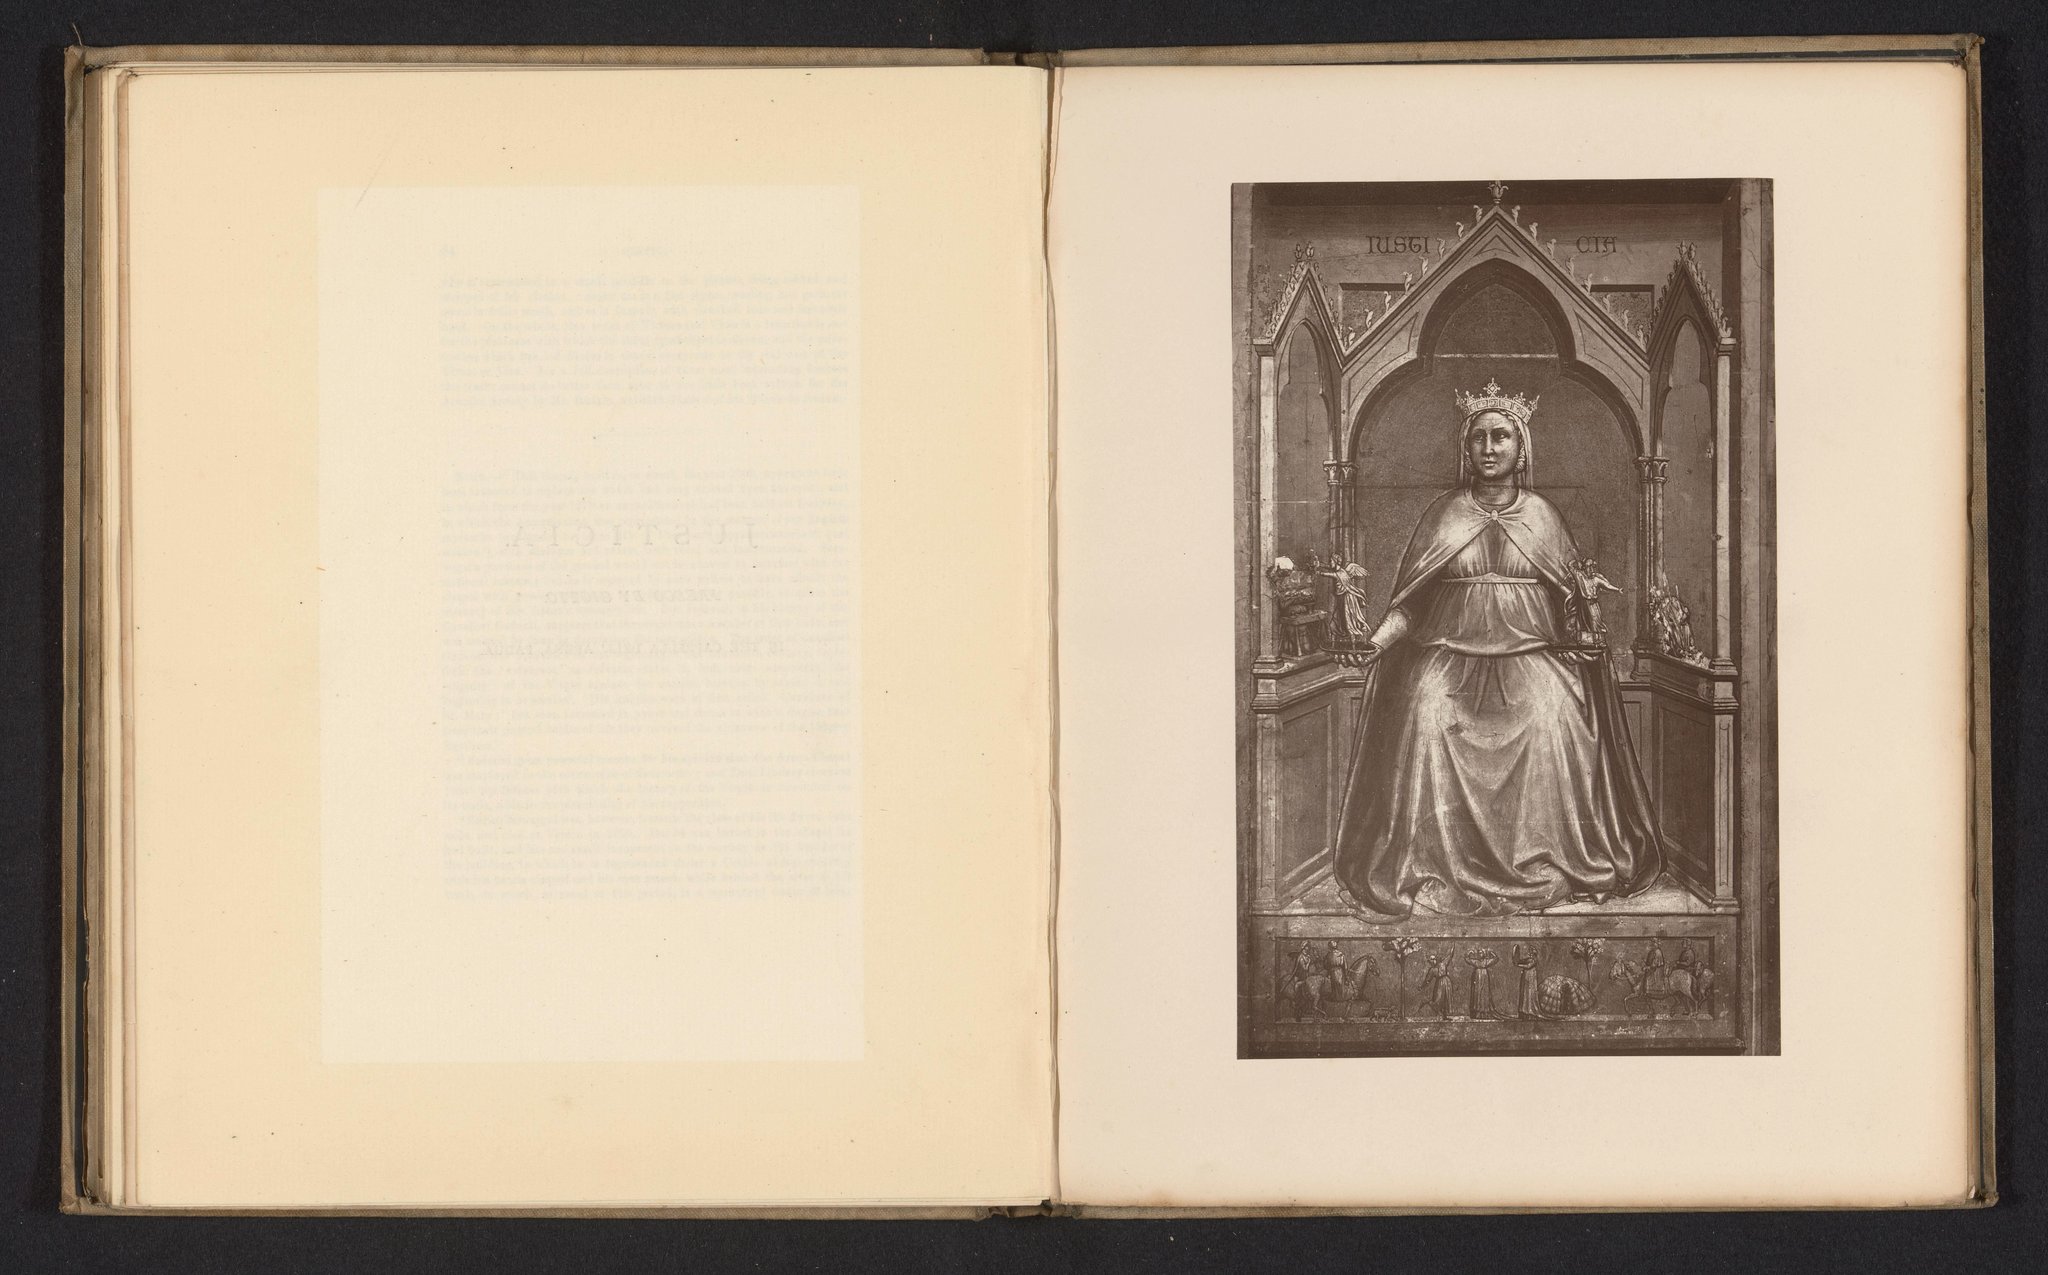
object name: page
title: Fotoreproductie van een fresco, voorstellende de Rechtvaardigheid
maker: Anonymous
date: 1870-1880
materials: paper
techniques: woodburytype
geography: padua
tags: justice; 'forza alla giustitia sottoposta', 'giustitia', 'giustitia retta', 'giustitia rigorosa', 'impietà e violenza soggetta alla giustitia' (ripa)